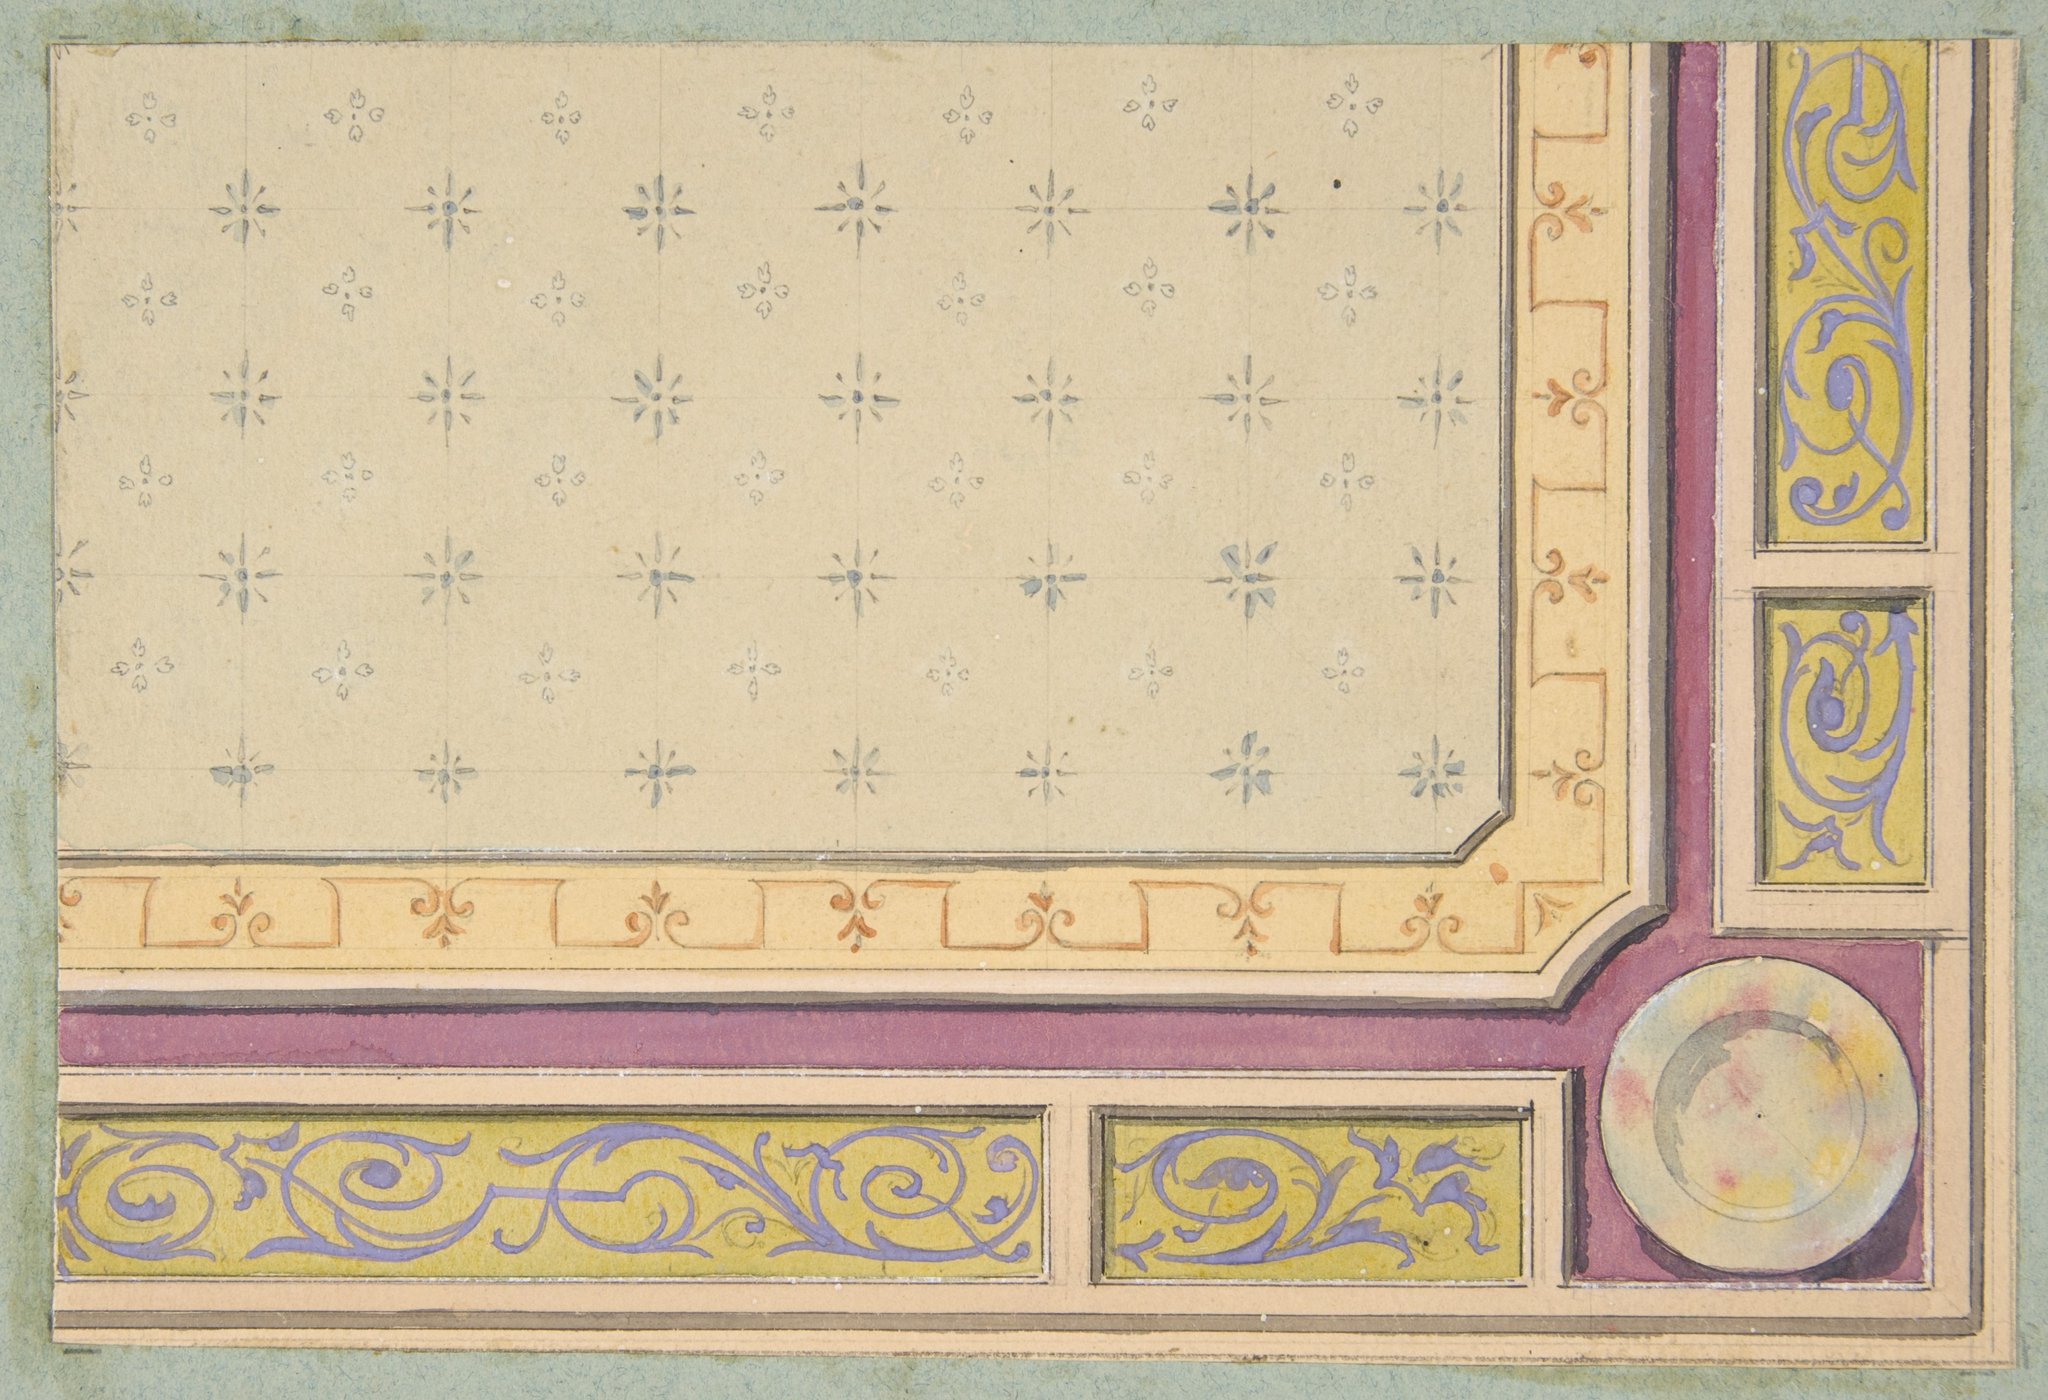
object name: drawing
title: Design for a ceiling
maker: jules-edmond-charles lachaise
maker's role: artist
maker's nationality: french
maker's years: 1897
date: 1851-1900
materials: gouache, graphite, ink, watercolor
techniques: pen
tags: architecture